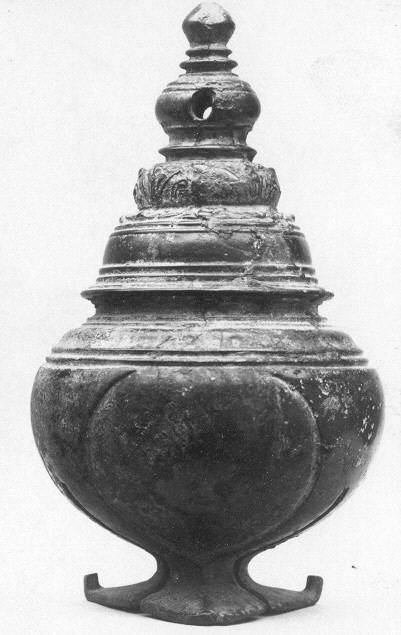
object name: bell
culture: javanese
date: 1001-1100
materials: bronze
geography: indonesia